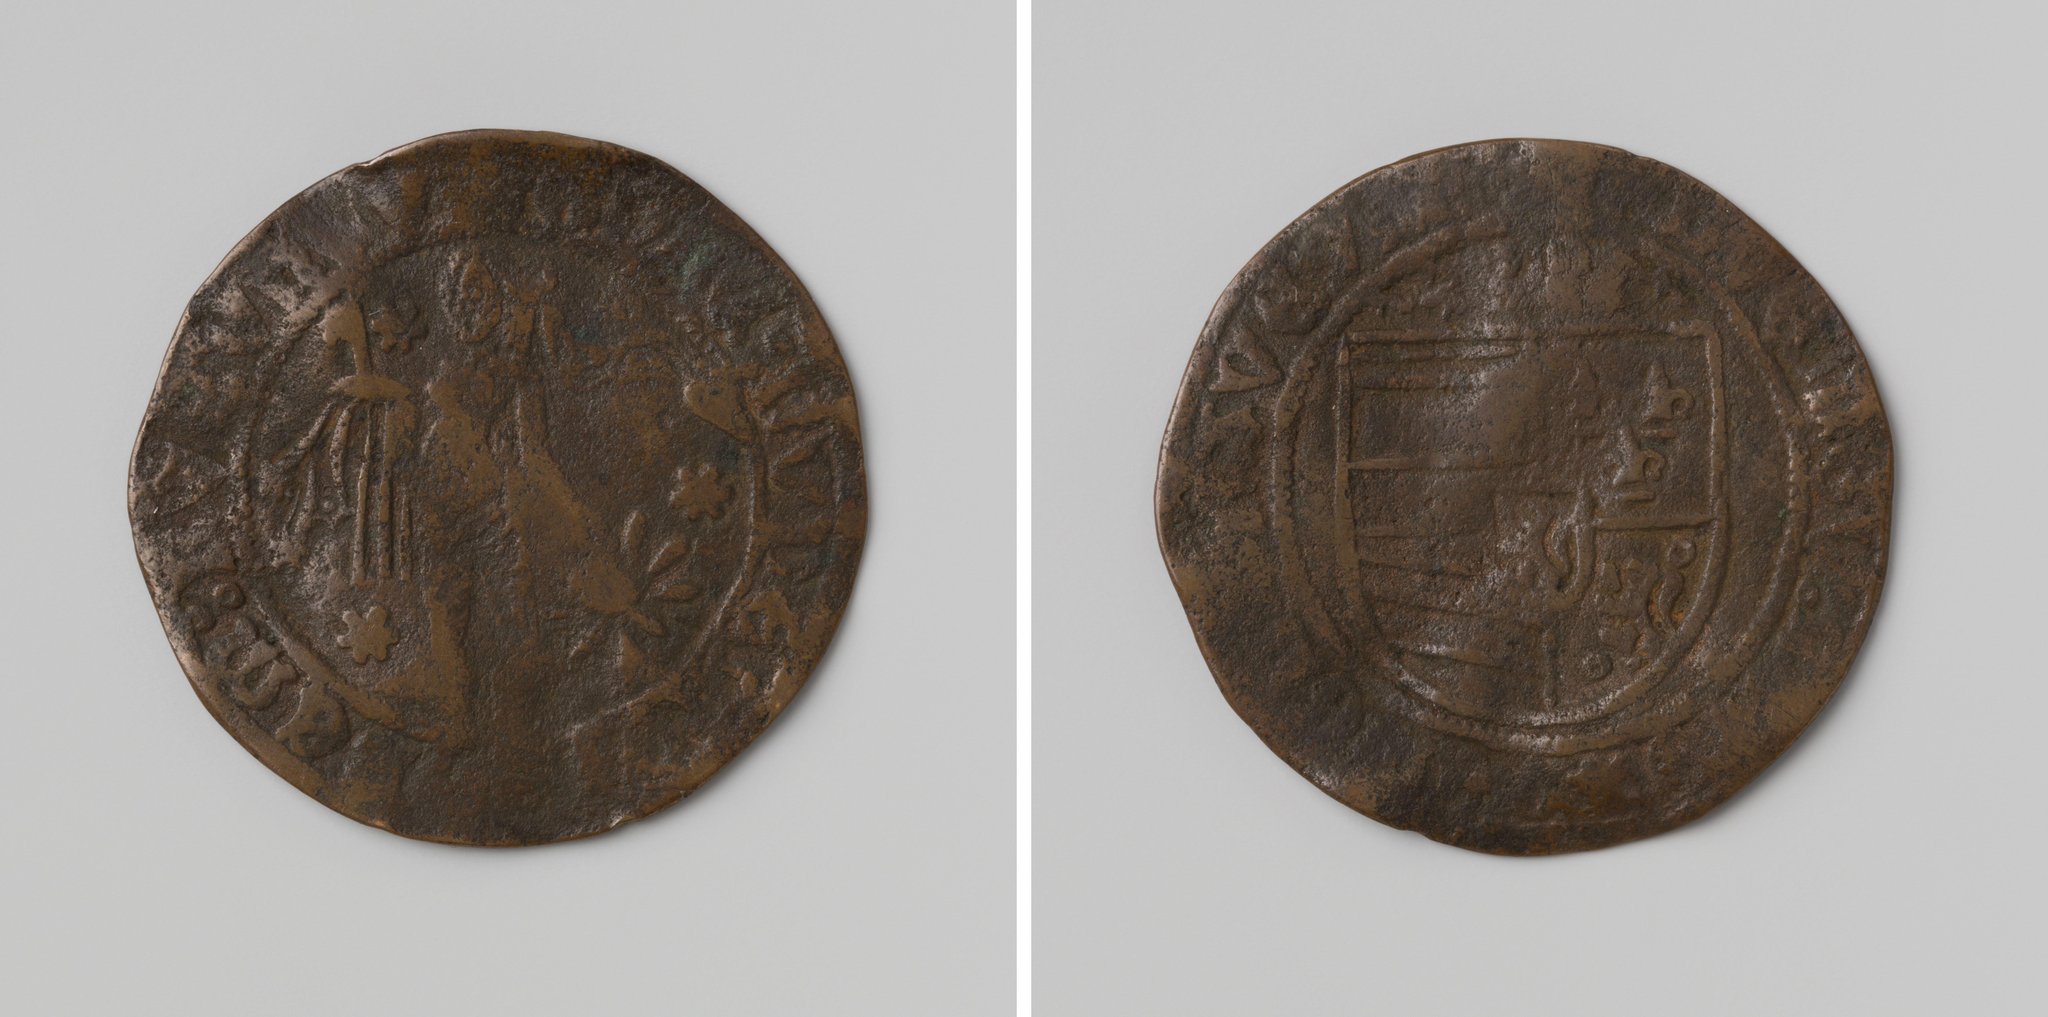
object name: jeton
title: Filips de Schone, hertog van Bourgondie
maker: Anonymous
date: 1496-1508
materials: copper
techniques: striking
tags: bruges, filips de schone (hertog van bourgondië)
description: Koperen penning. Voorzijde: vrouw met bloem [?] in linker- en vuurslag, waar vonken afspatten [?] in rechterhand binnen omschrift. Keerzijde: wapenschild binnen omschrift